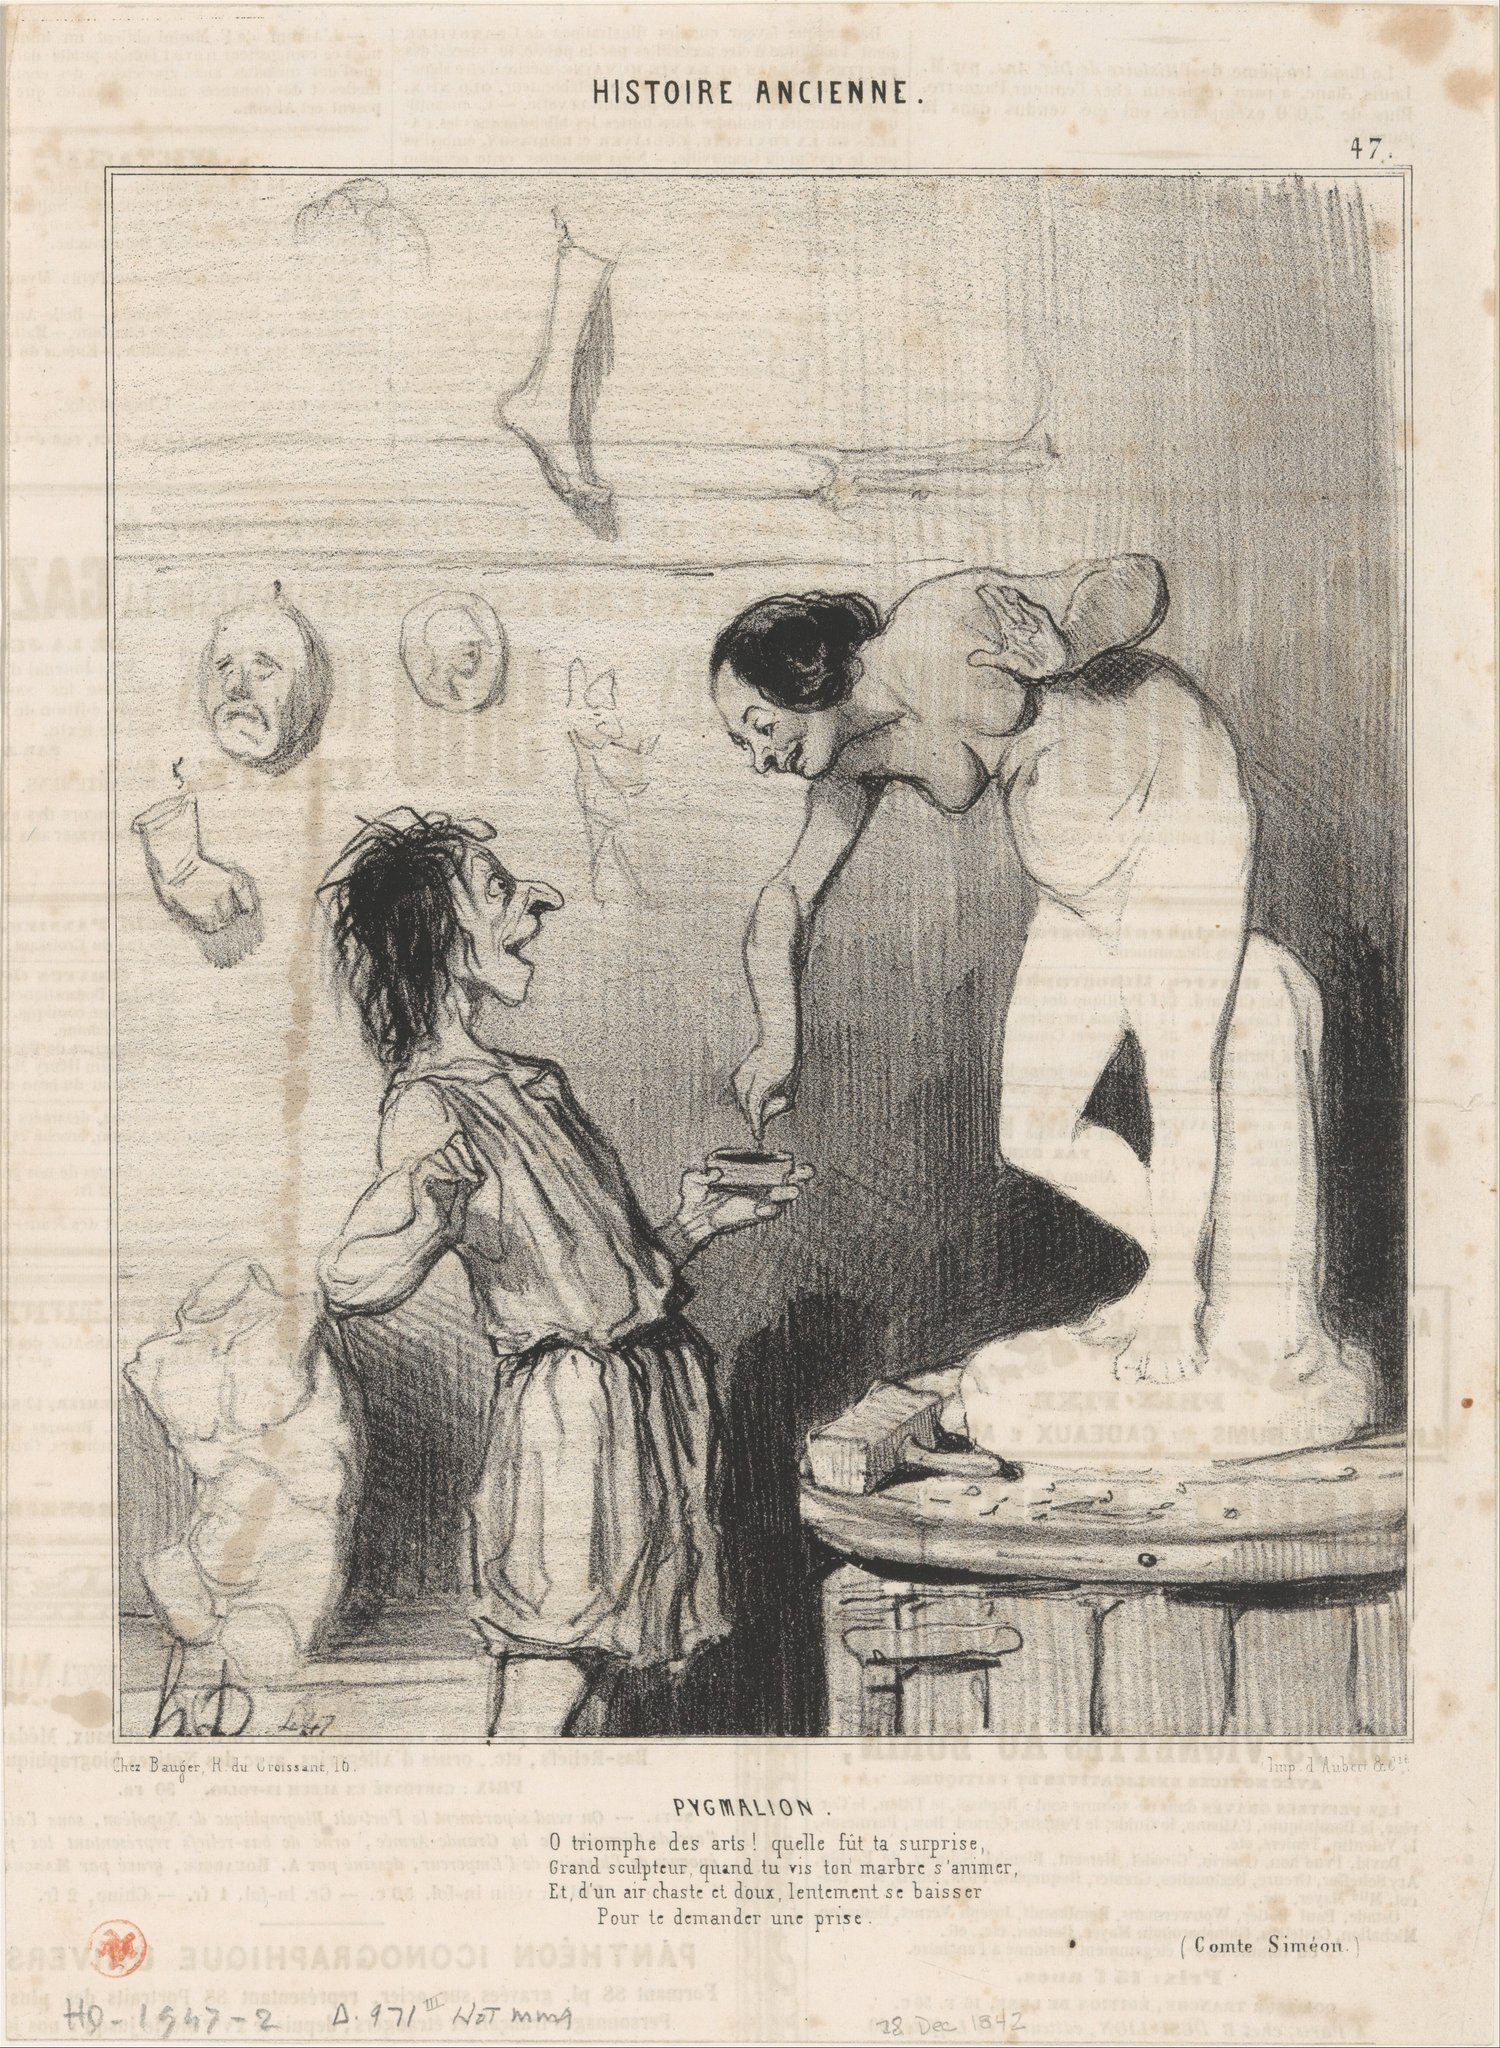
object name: print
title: Pygmalion, from Histoire Ancienne, published in Le Charivari, December 28, 1842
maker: honoré daumier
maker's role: artist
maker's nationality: french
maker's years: 1808-1879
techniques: lithograph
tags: men,female nudes